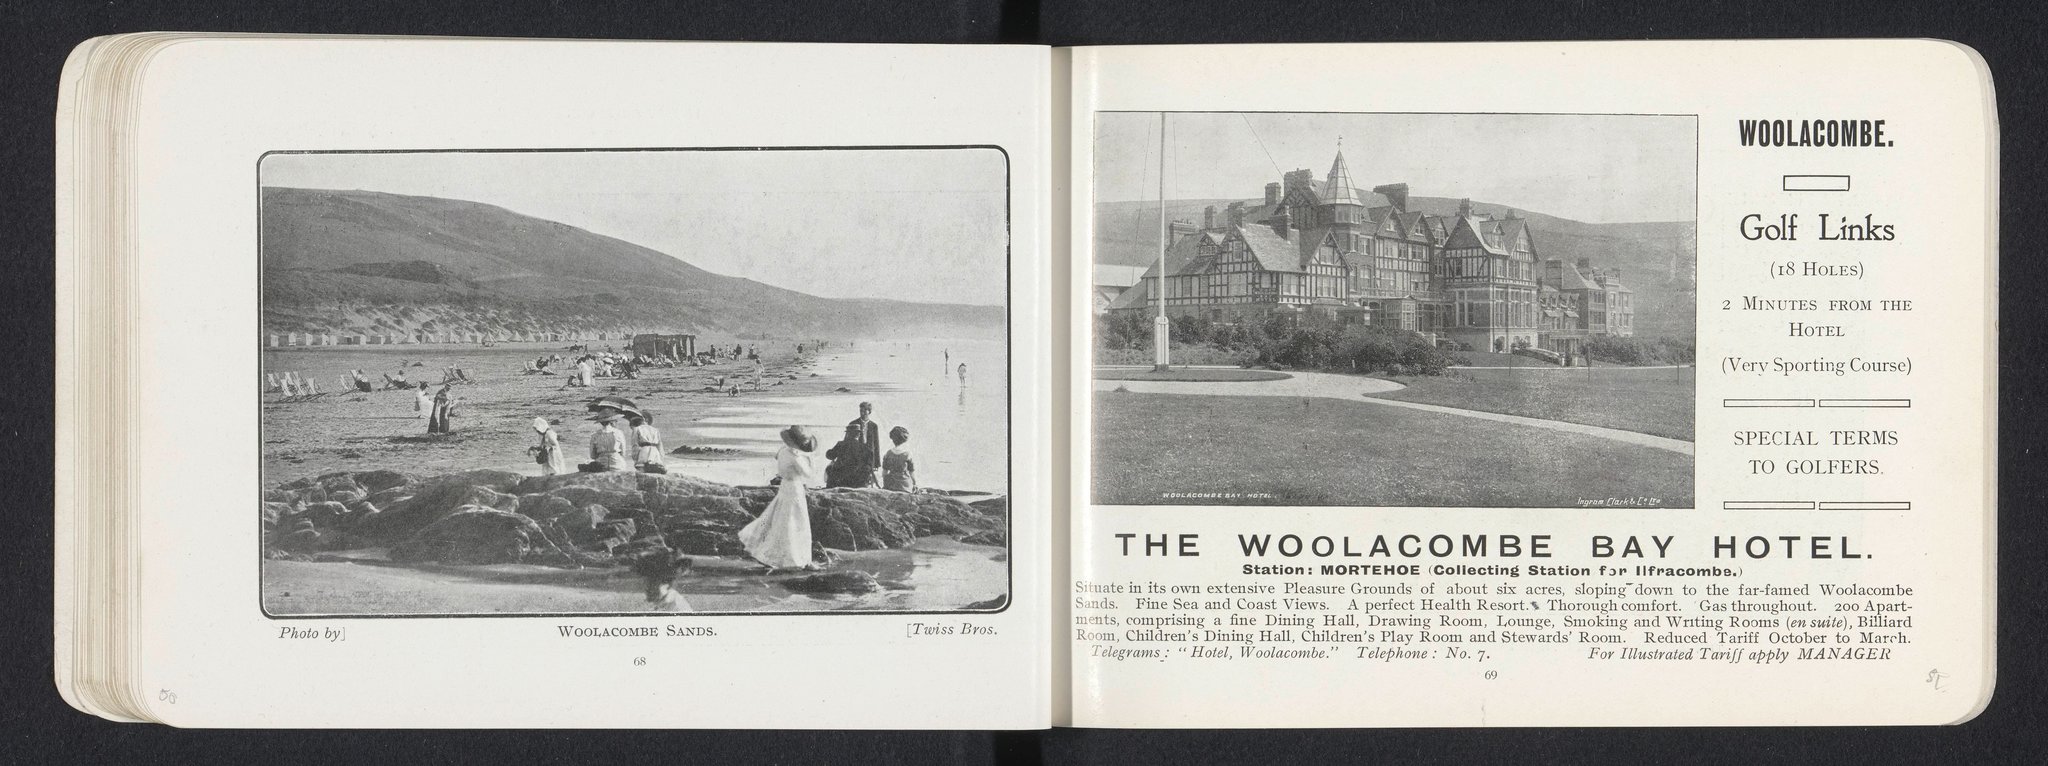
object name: photomechanical print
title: Woolacombe sands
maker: Anonymous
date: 1900-1920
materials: paper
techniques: autotype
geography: devon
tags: beach (as place of recreation)